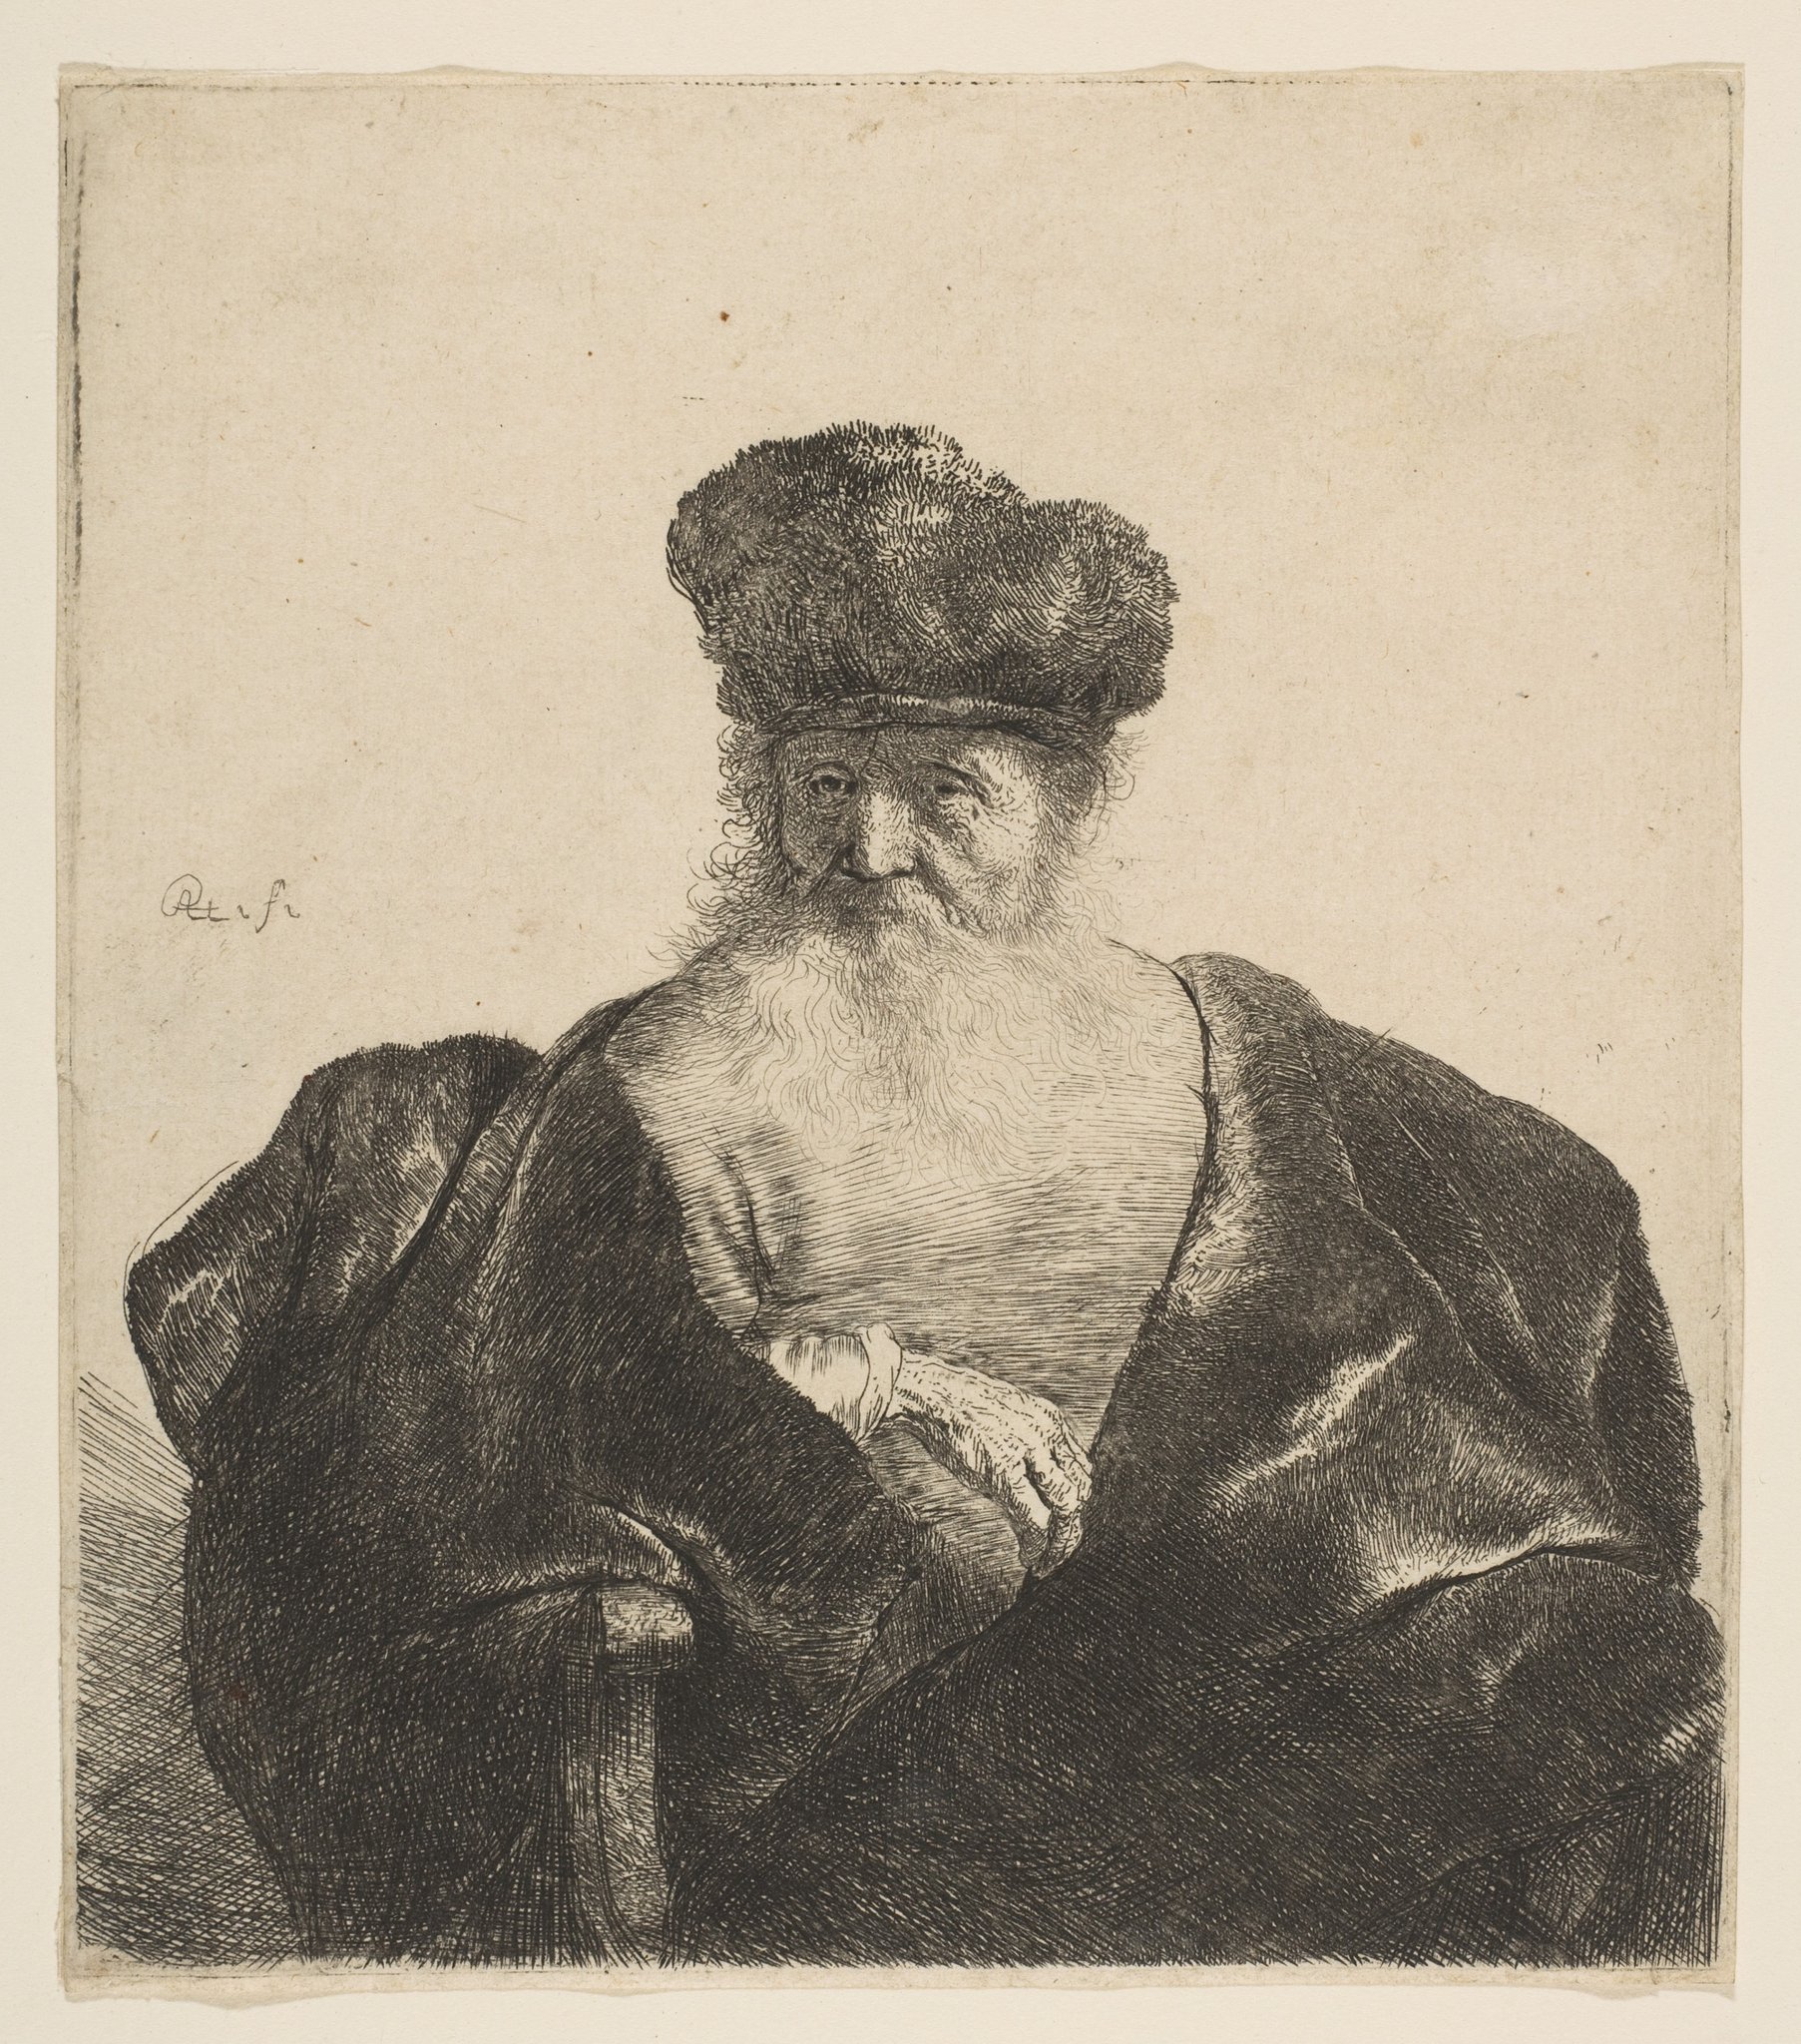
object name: print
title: Old Man with Beard, Fur Cap, and Velvet Cloak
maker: rembrandt van rijn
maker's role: artist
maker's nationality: dutch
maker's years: 1606-1669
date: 1631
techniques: etching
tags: men,portraits